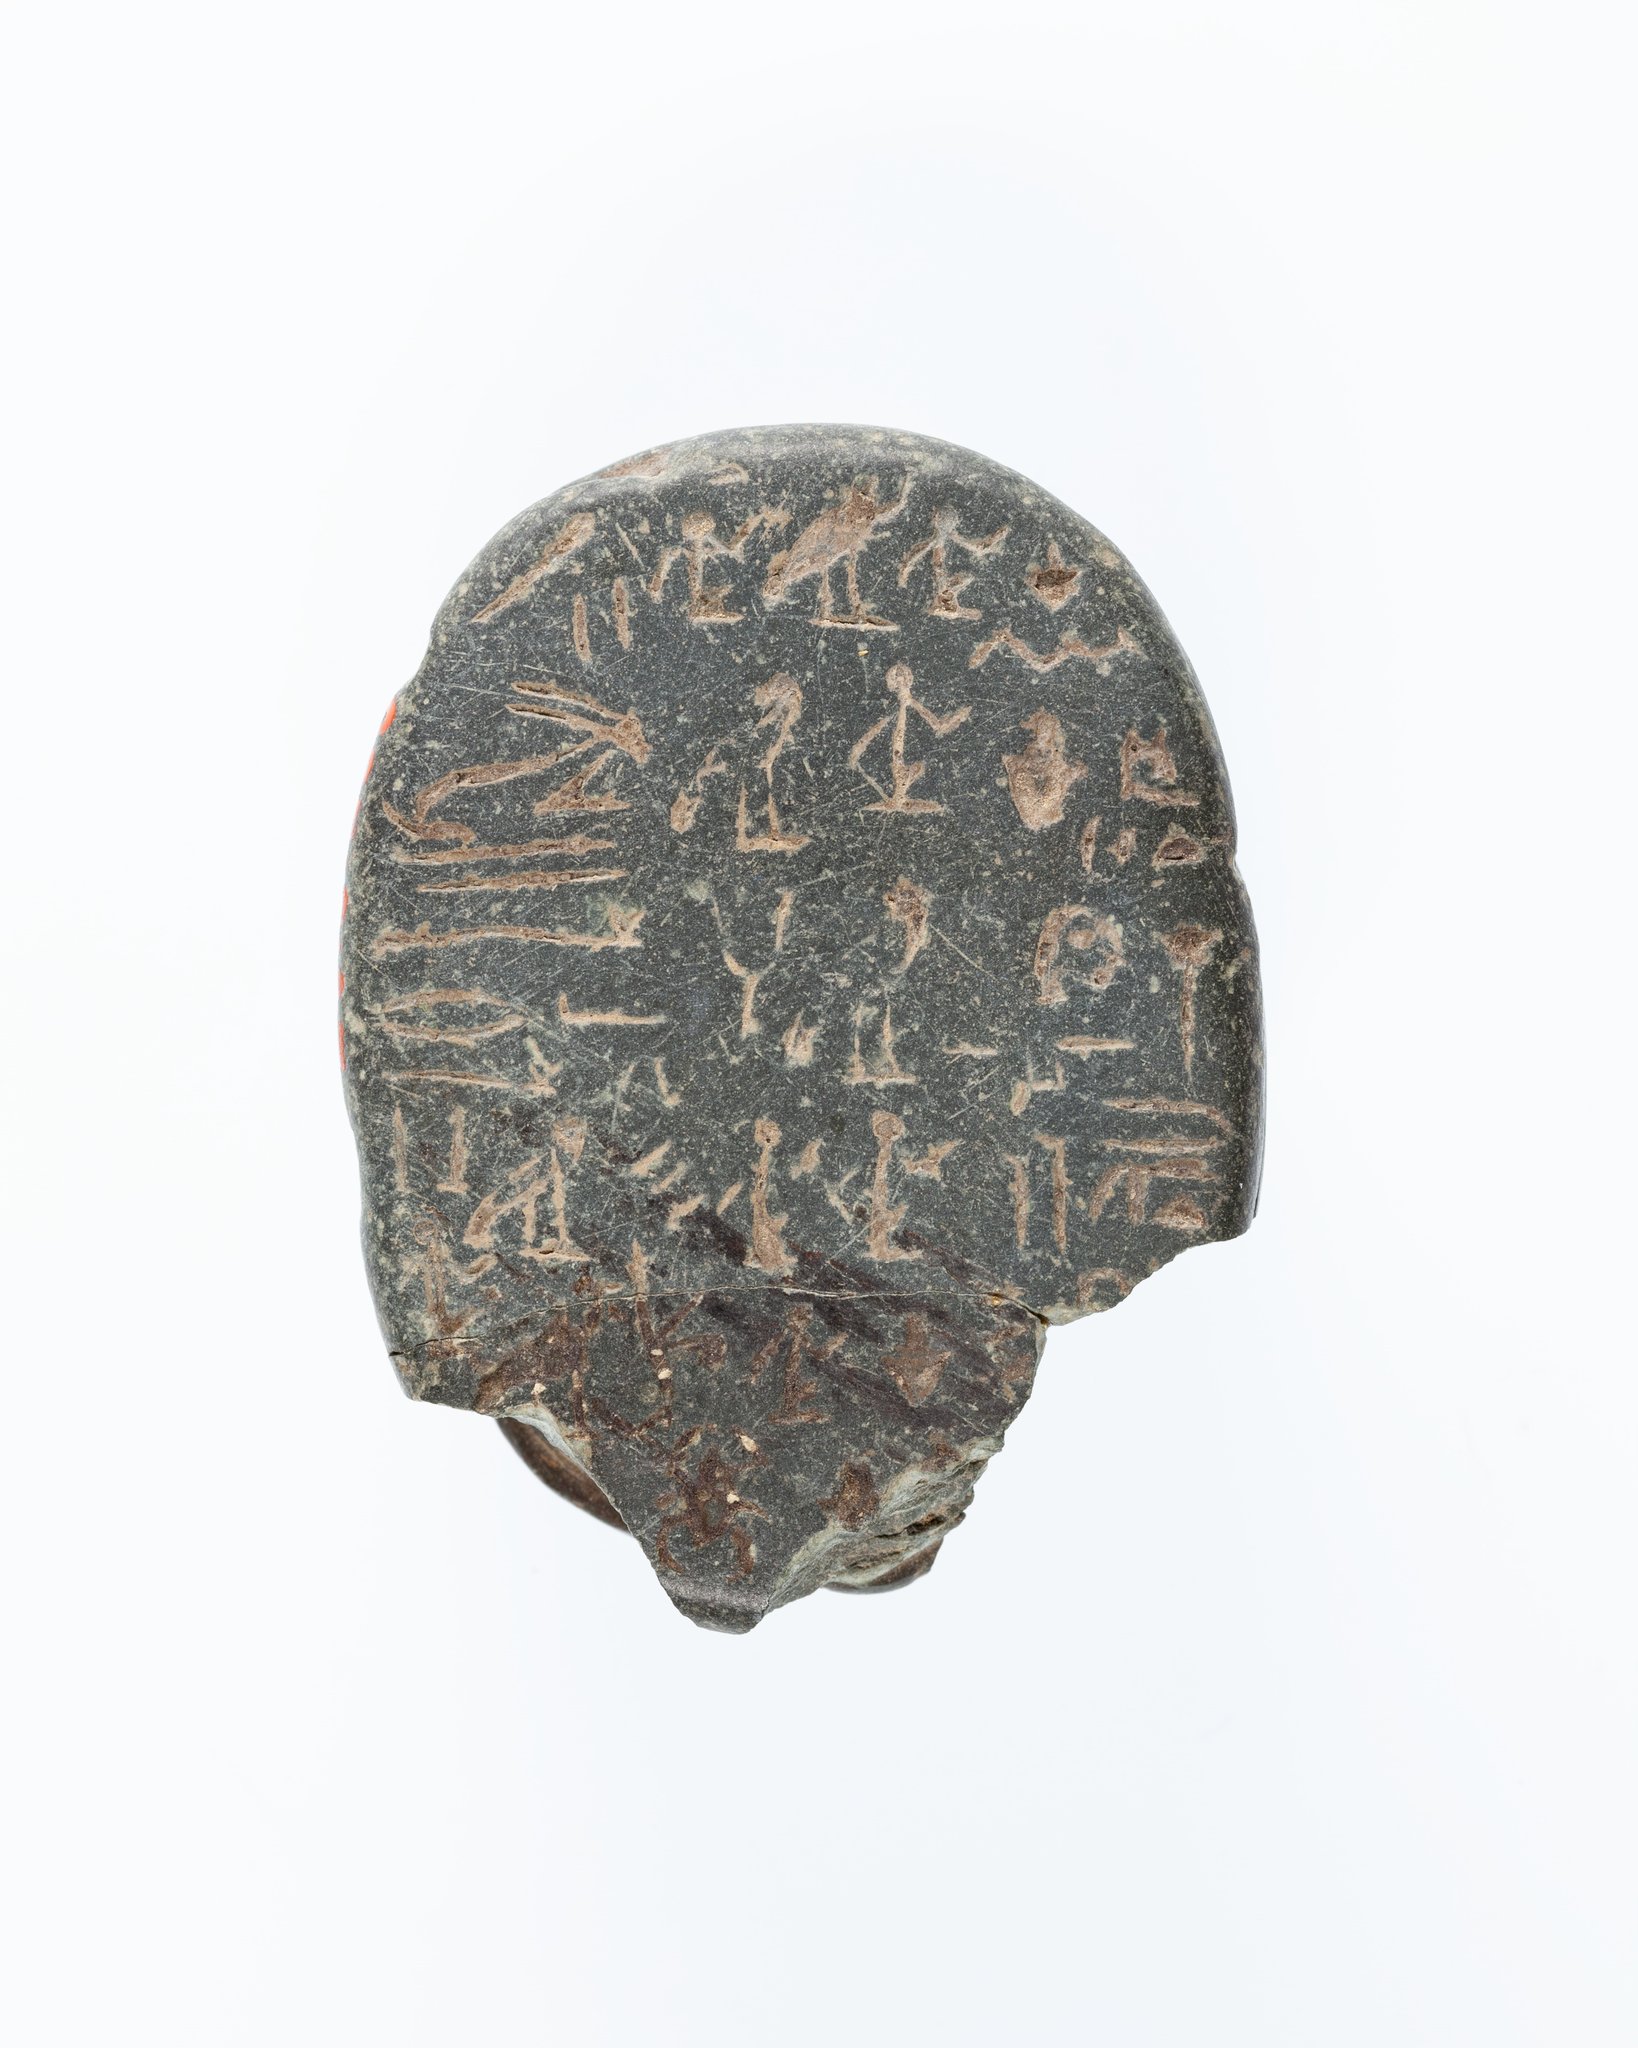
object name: heart scarab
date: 1070-332 BCE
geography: egypt